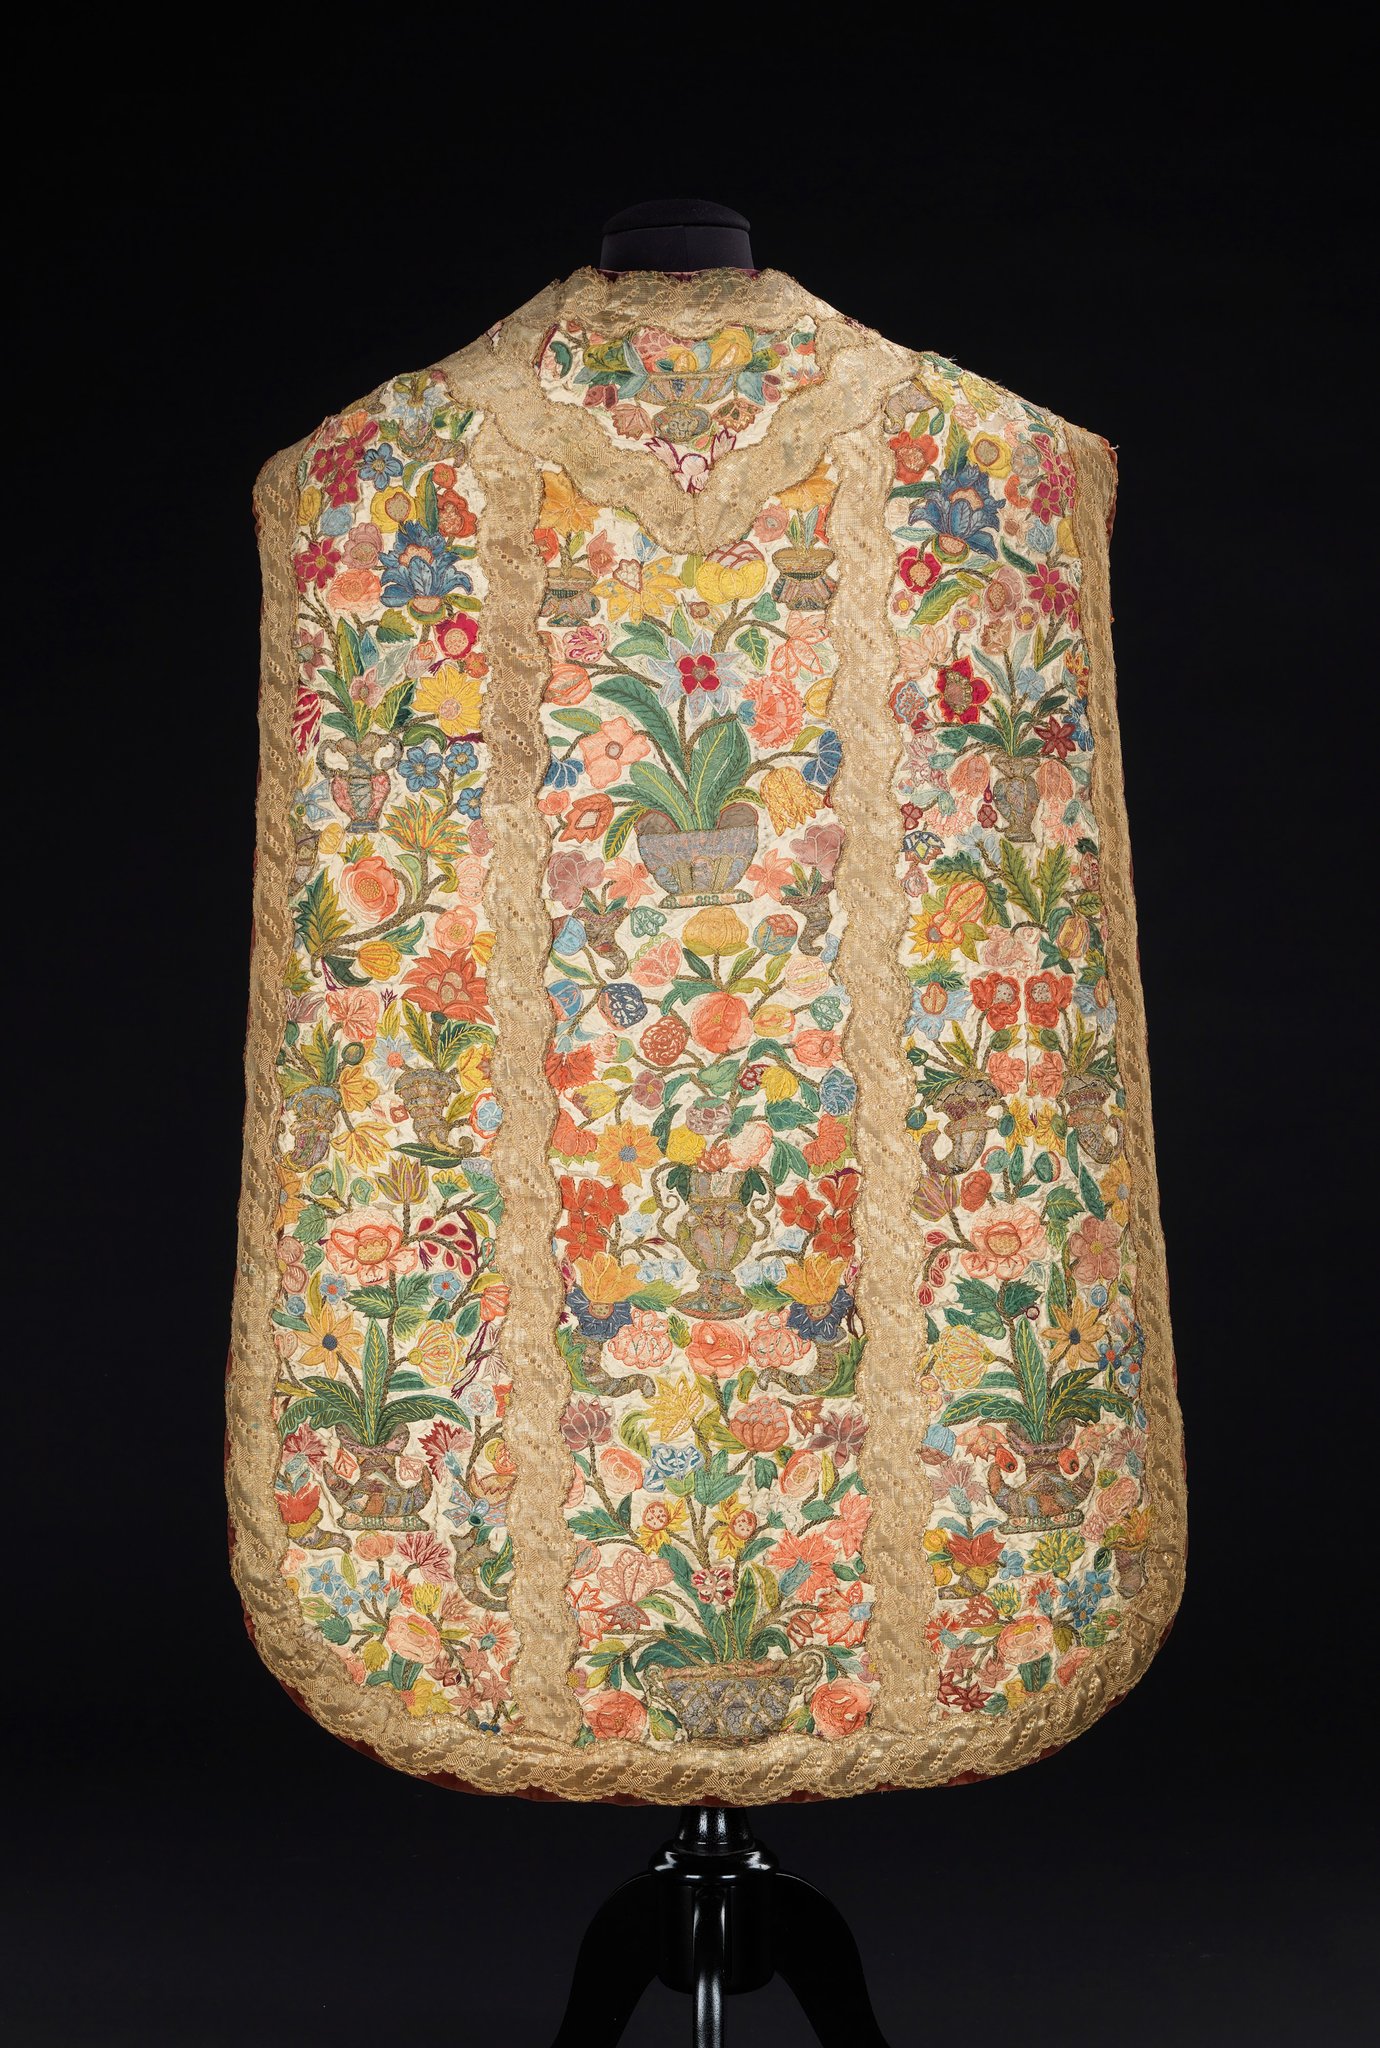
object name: chasuble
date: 1834-1866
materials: metal, silk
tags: flowers,leaves